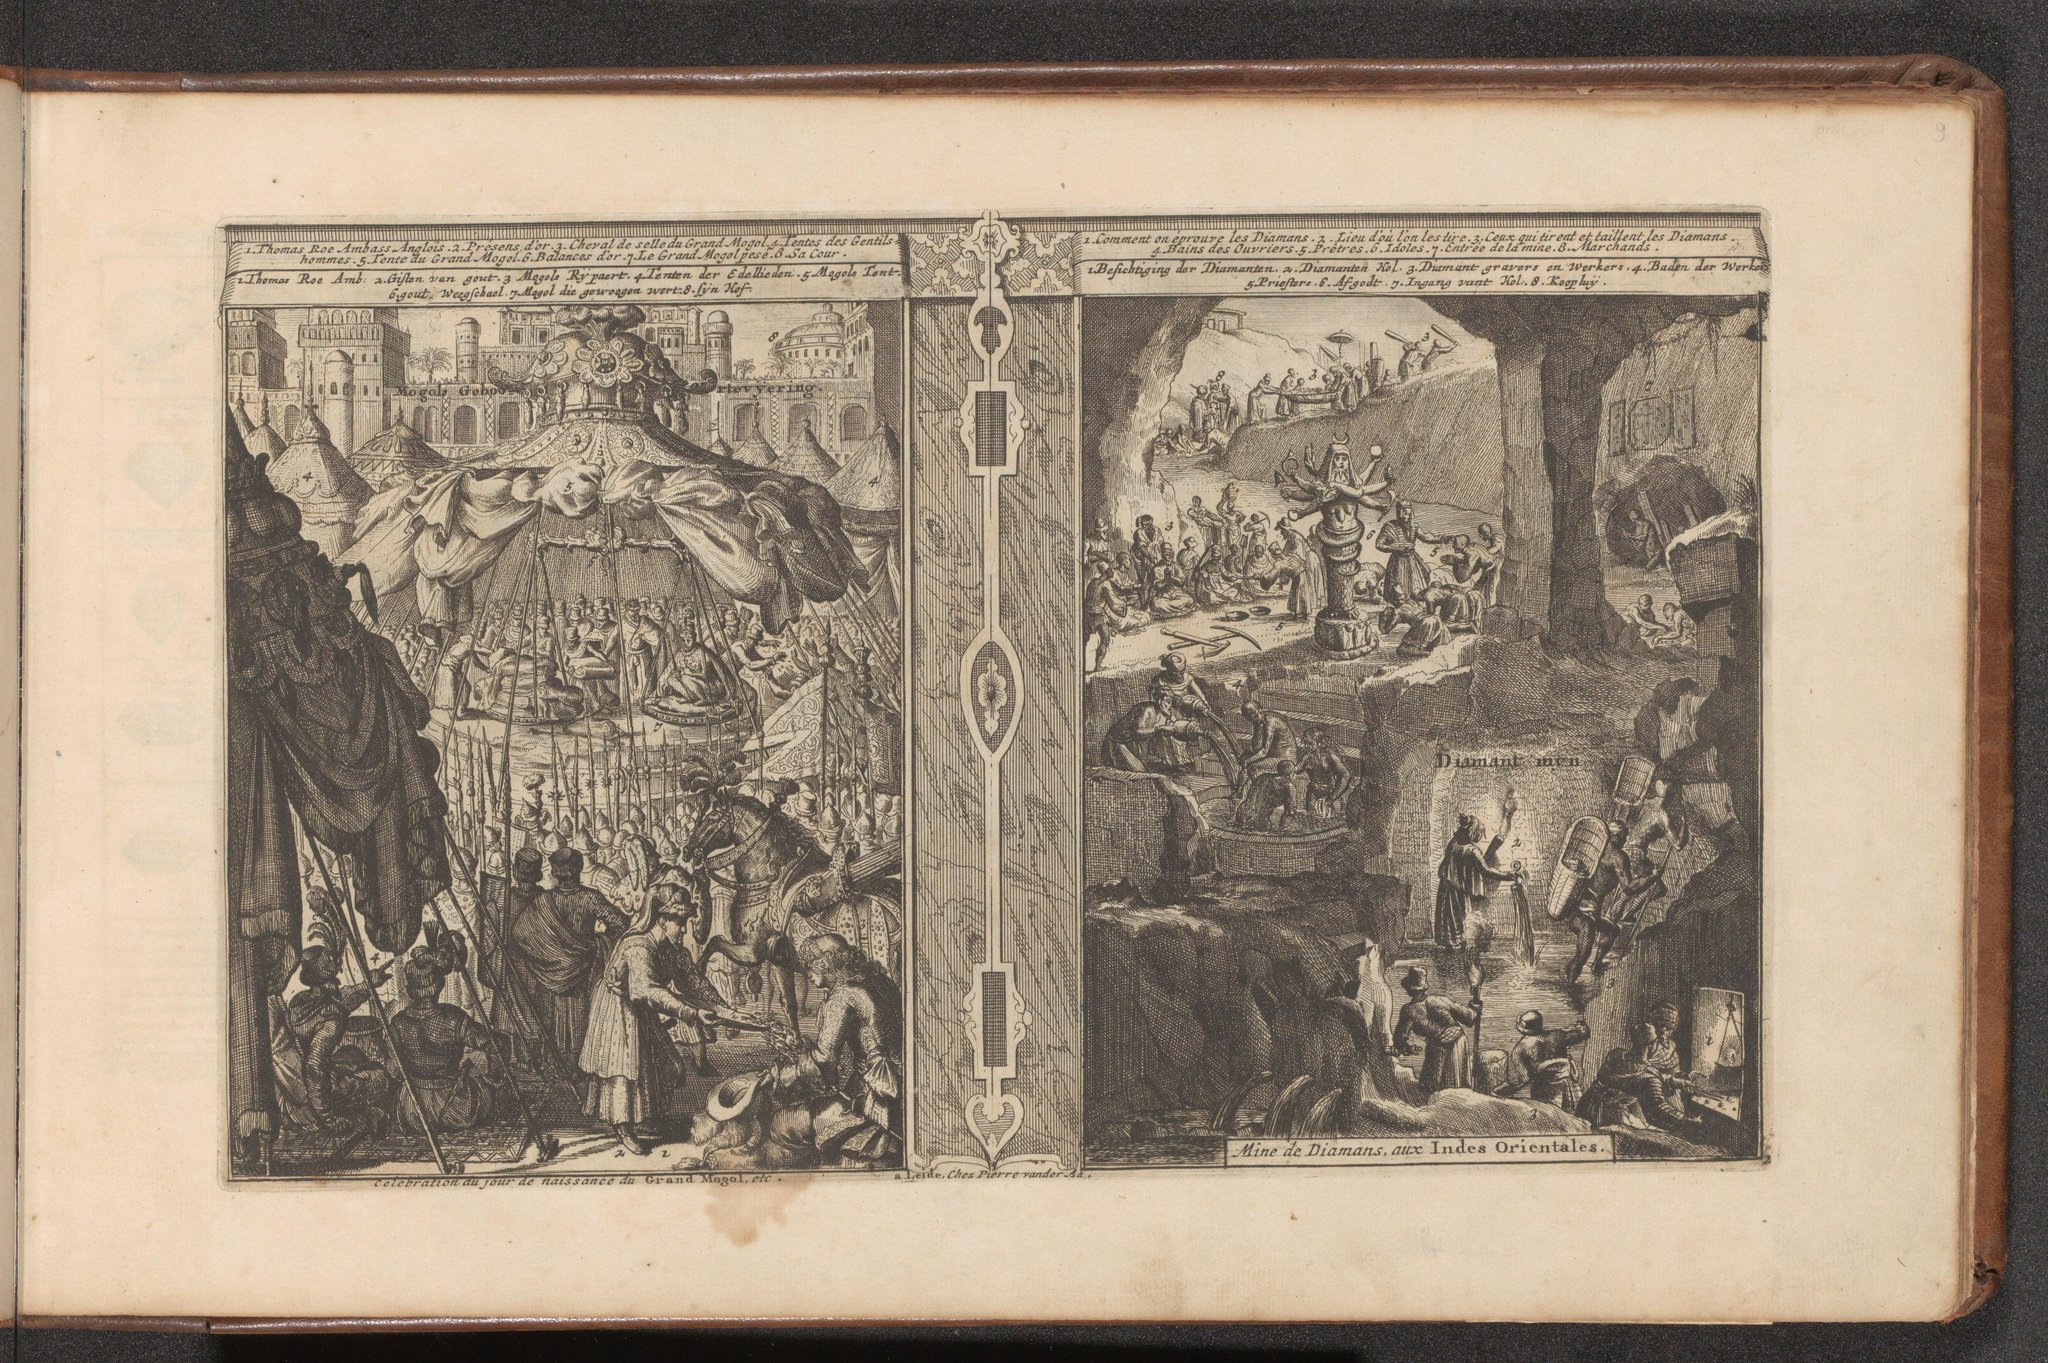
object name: album leaf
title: Mogols Geboortevyering / Celebration au jour de naissance du Grand Mogol, etc. // Diamant myn / Mine de Diamans, aux Indes Orientales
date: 1682-1733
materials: paper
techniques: etching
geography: leiden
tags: asiatic races and peoples, precious and semiprecious stones: diamond, mongolians, festivities, mine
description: Voorstelling in twee delen. Links de geboorteviering van Mongolië. In een tent wordt de vorst van Mongolië gewogen. Als tegenwicht worden zakken met geld neergelegd. Edellieden kijken toe. Op de voorgrond krijgt de Engelse ambassadeur Thomas Roe een schotel met goud. De rechter voorstelling toont een diamantmijn. Priesters knielen voor een beeld. Met een legenda in het Frans en het Nederlands. De prent maakt deel uit van een album.